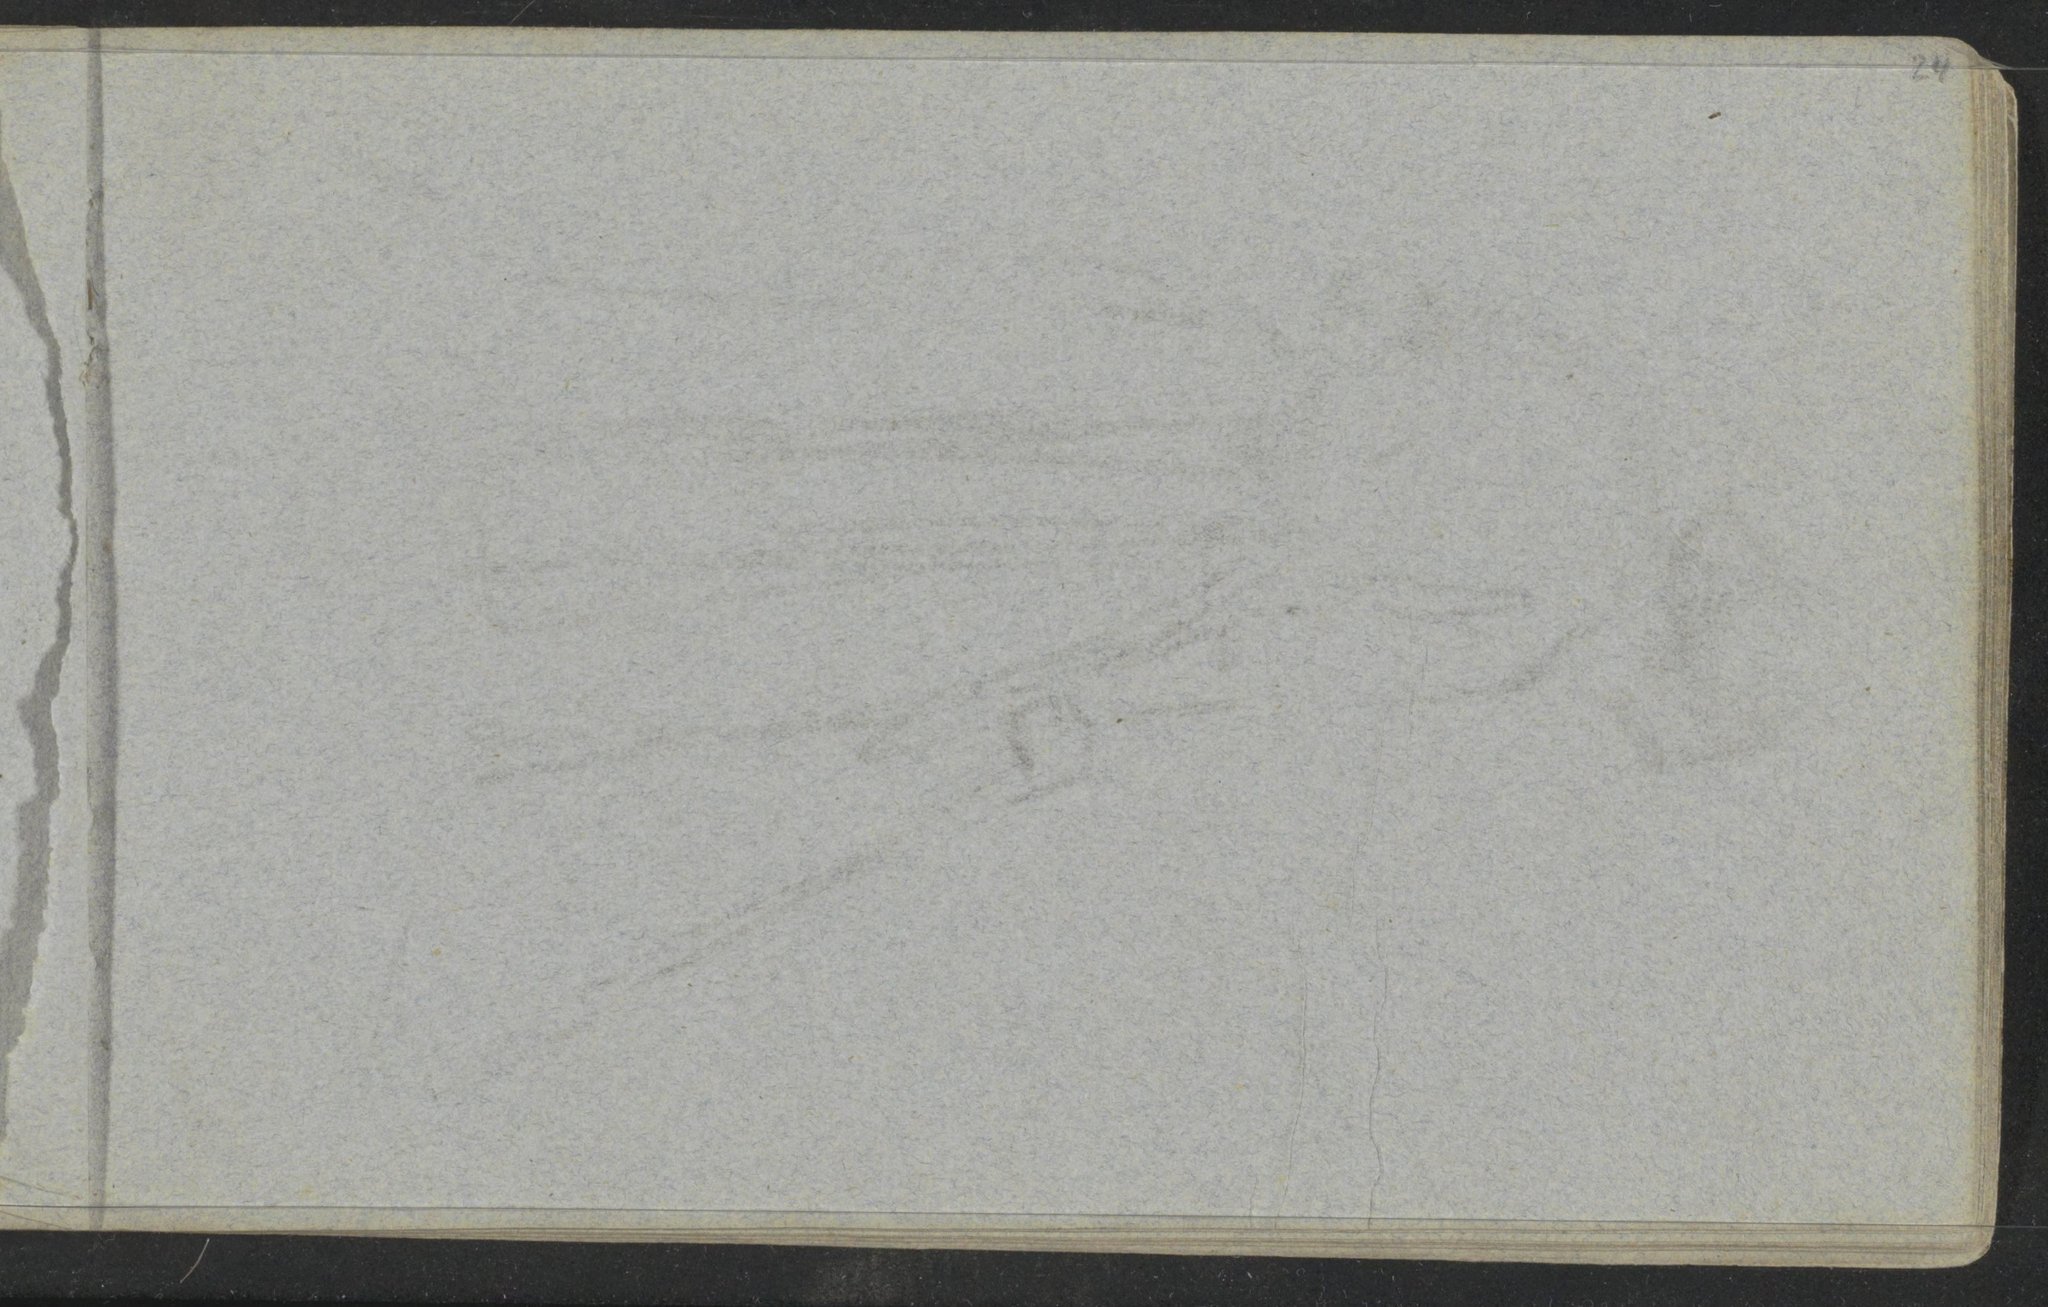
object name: sketchbook leaf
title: Staand meisje, op de rug gezien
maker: matthijs maris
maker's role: draughtsman, painter, print maker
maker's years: 1839-1917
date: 1849-1917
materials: paper, pencil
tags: girl (child between toddler and youth)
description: Blad 24 recto uit een schetsboek met 35 bladen.